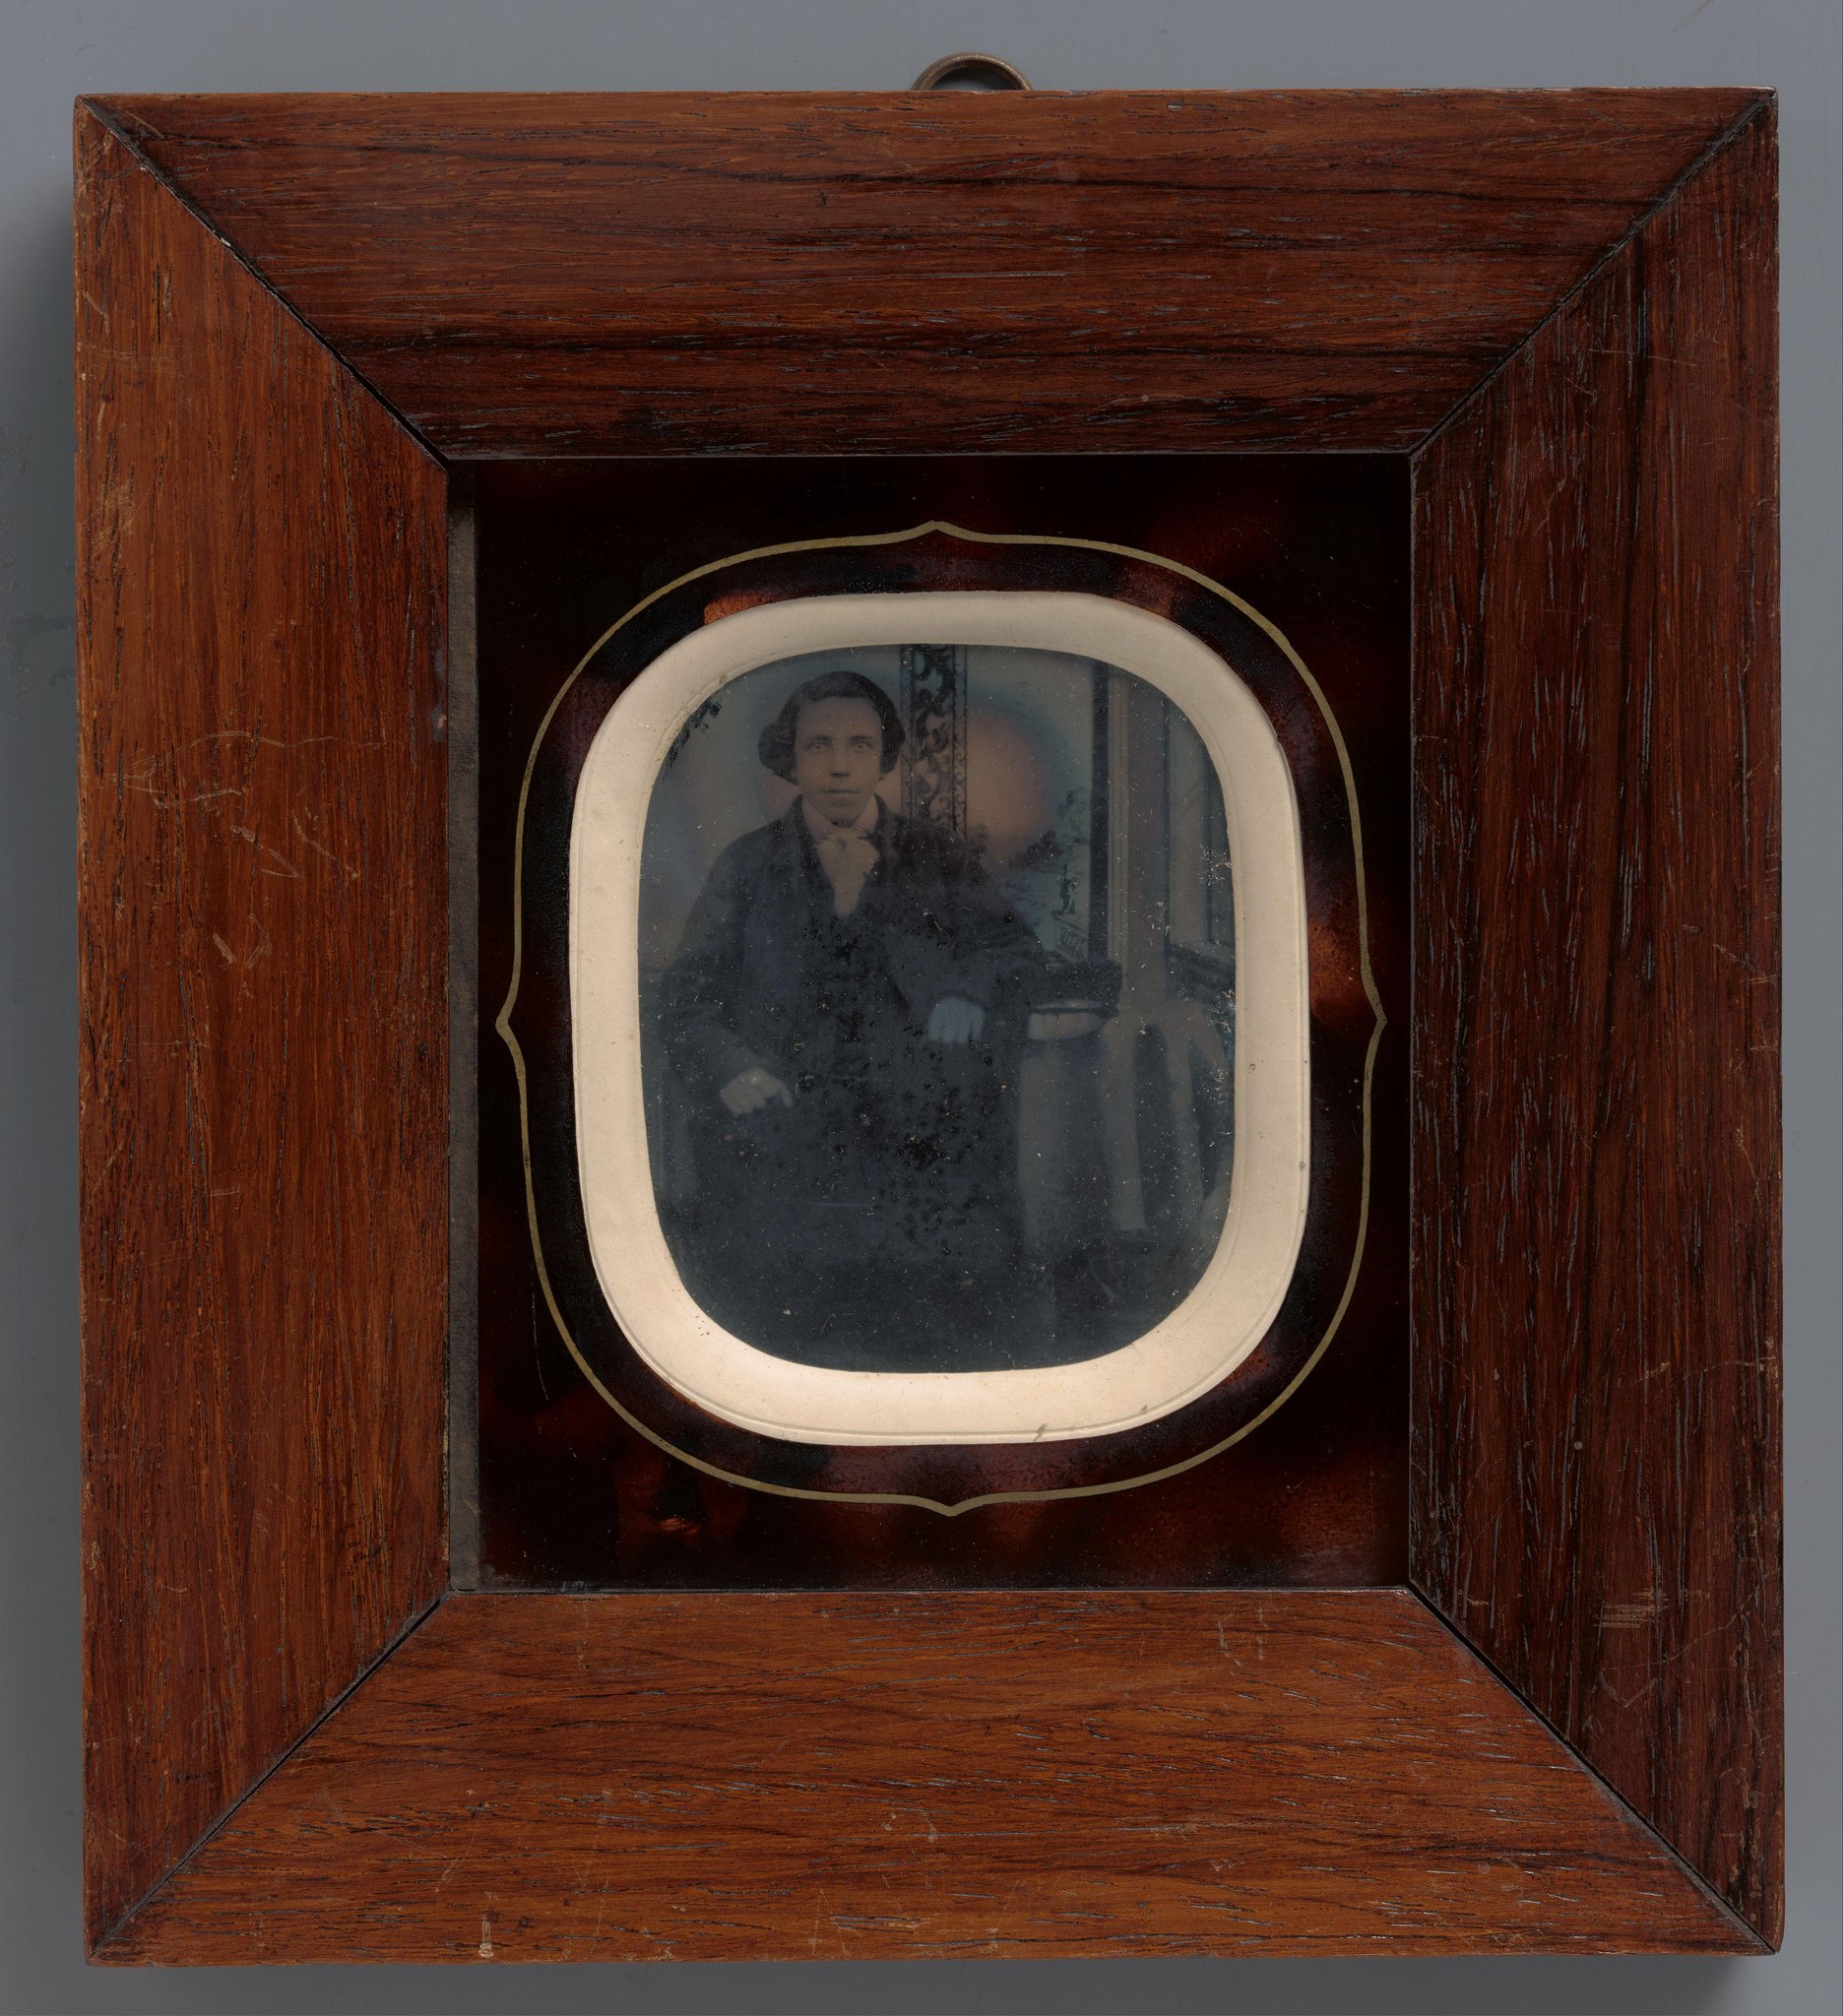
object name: frame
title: Portret van een onbekende jongen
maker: h. shearman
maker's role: fotograaf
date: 1840-1860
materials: glass, wood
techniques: daguerreotype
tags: sitting figure, boy (child between toddler and youth), historical persons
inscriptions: inscription: ‘From/ H. Shearman/ Photographic Artist/ 4 Queen's terrace, Commercial Road/ opposite teh telegraphe station/ Portraits taken on paper, Oileloth or copied from/ photographic likenesses or oil paintings [...]./ Portraits taken for Brooches, Lockets, Pins (...)’